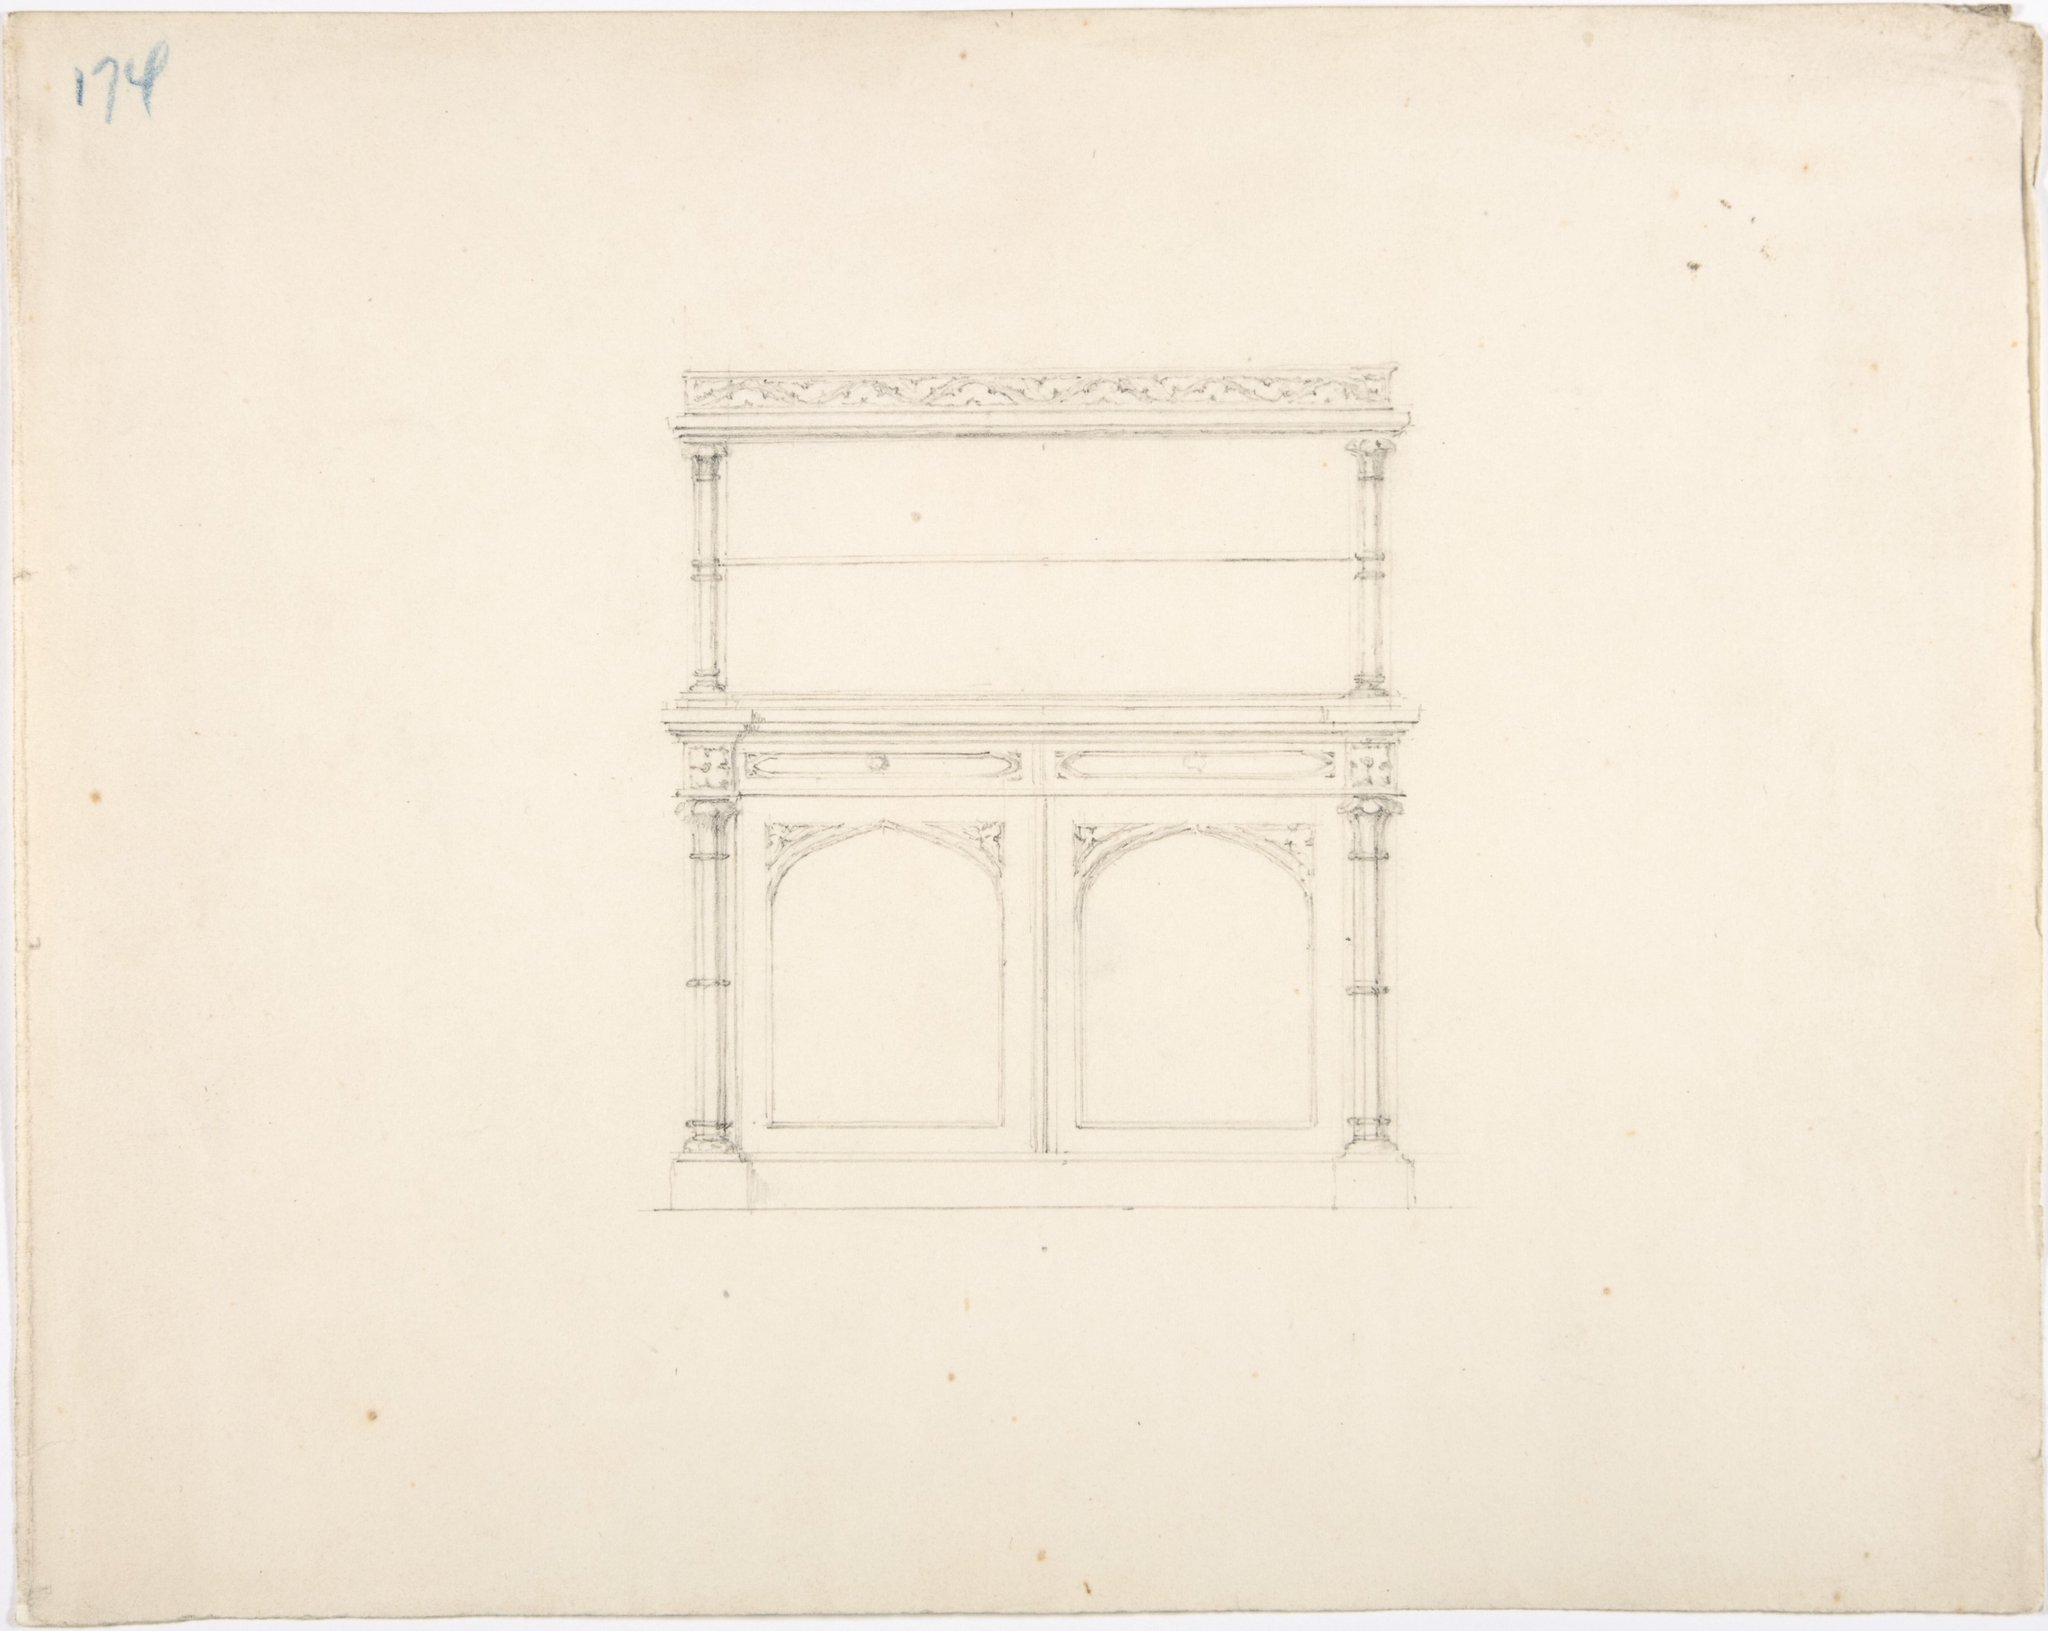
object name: drawing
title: Design for a Gothic Style Mirrored Cabinet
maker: anonymous, british, 19th century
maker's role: artist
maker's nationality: british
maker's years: 1800-1900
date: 1801-1833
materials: graphite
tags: cabinets